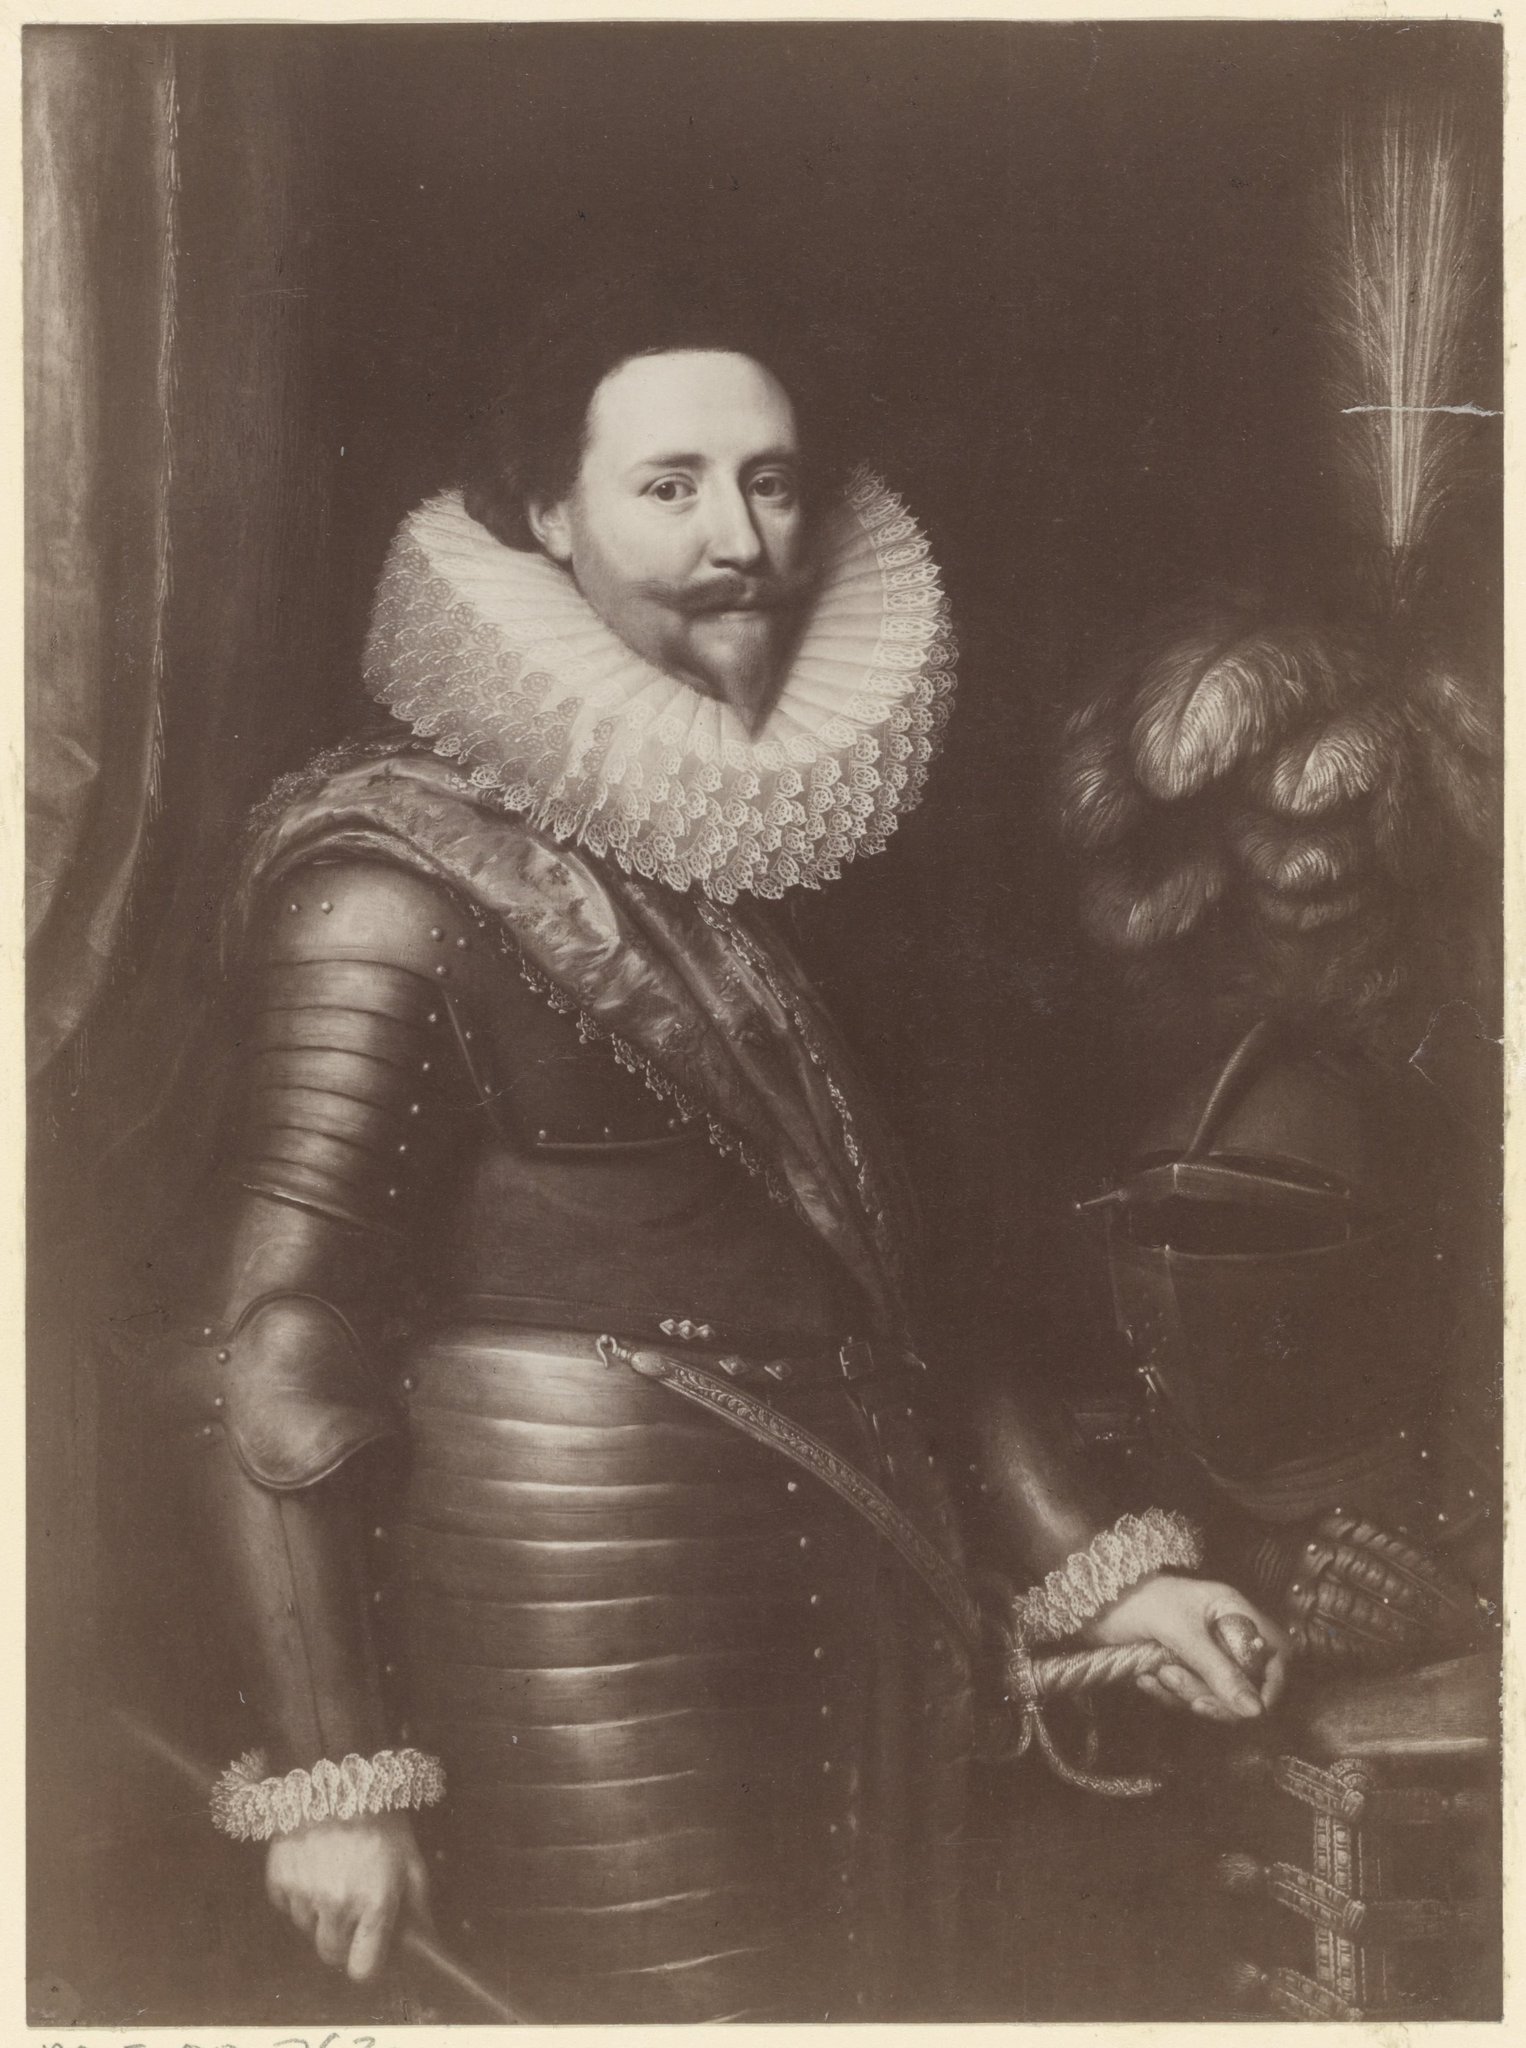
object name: photograph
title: Portret van Frederik Hendrik, prins van Oranje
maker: Anonymous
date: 1850-1930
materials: photographic support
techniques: photography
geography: netherlands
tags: delft, the hague, frederick henry (prince of orange)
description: De hier vermelde titel verwijst naar de hoogst verkregen titel van de geportretteerde, niet per se naar de titel die de geportretteerde op deze voorstelling draagt.